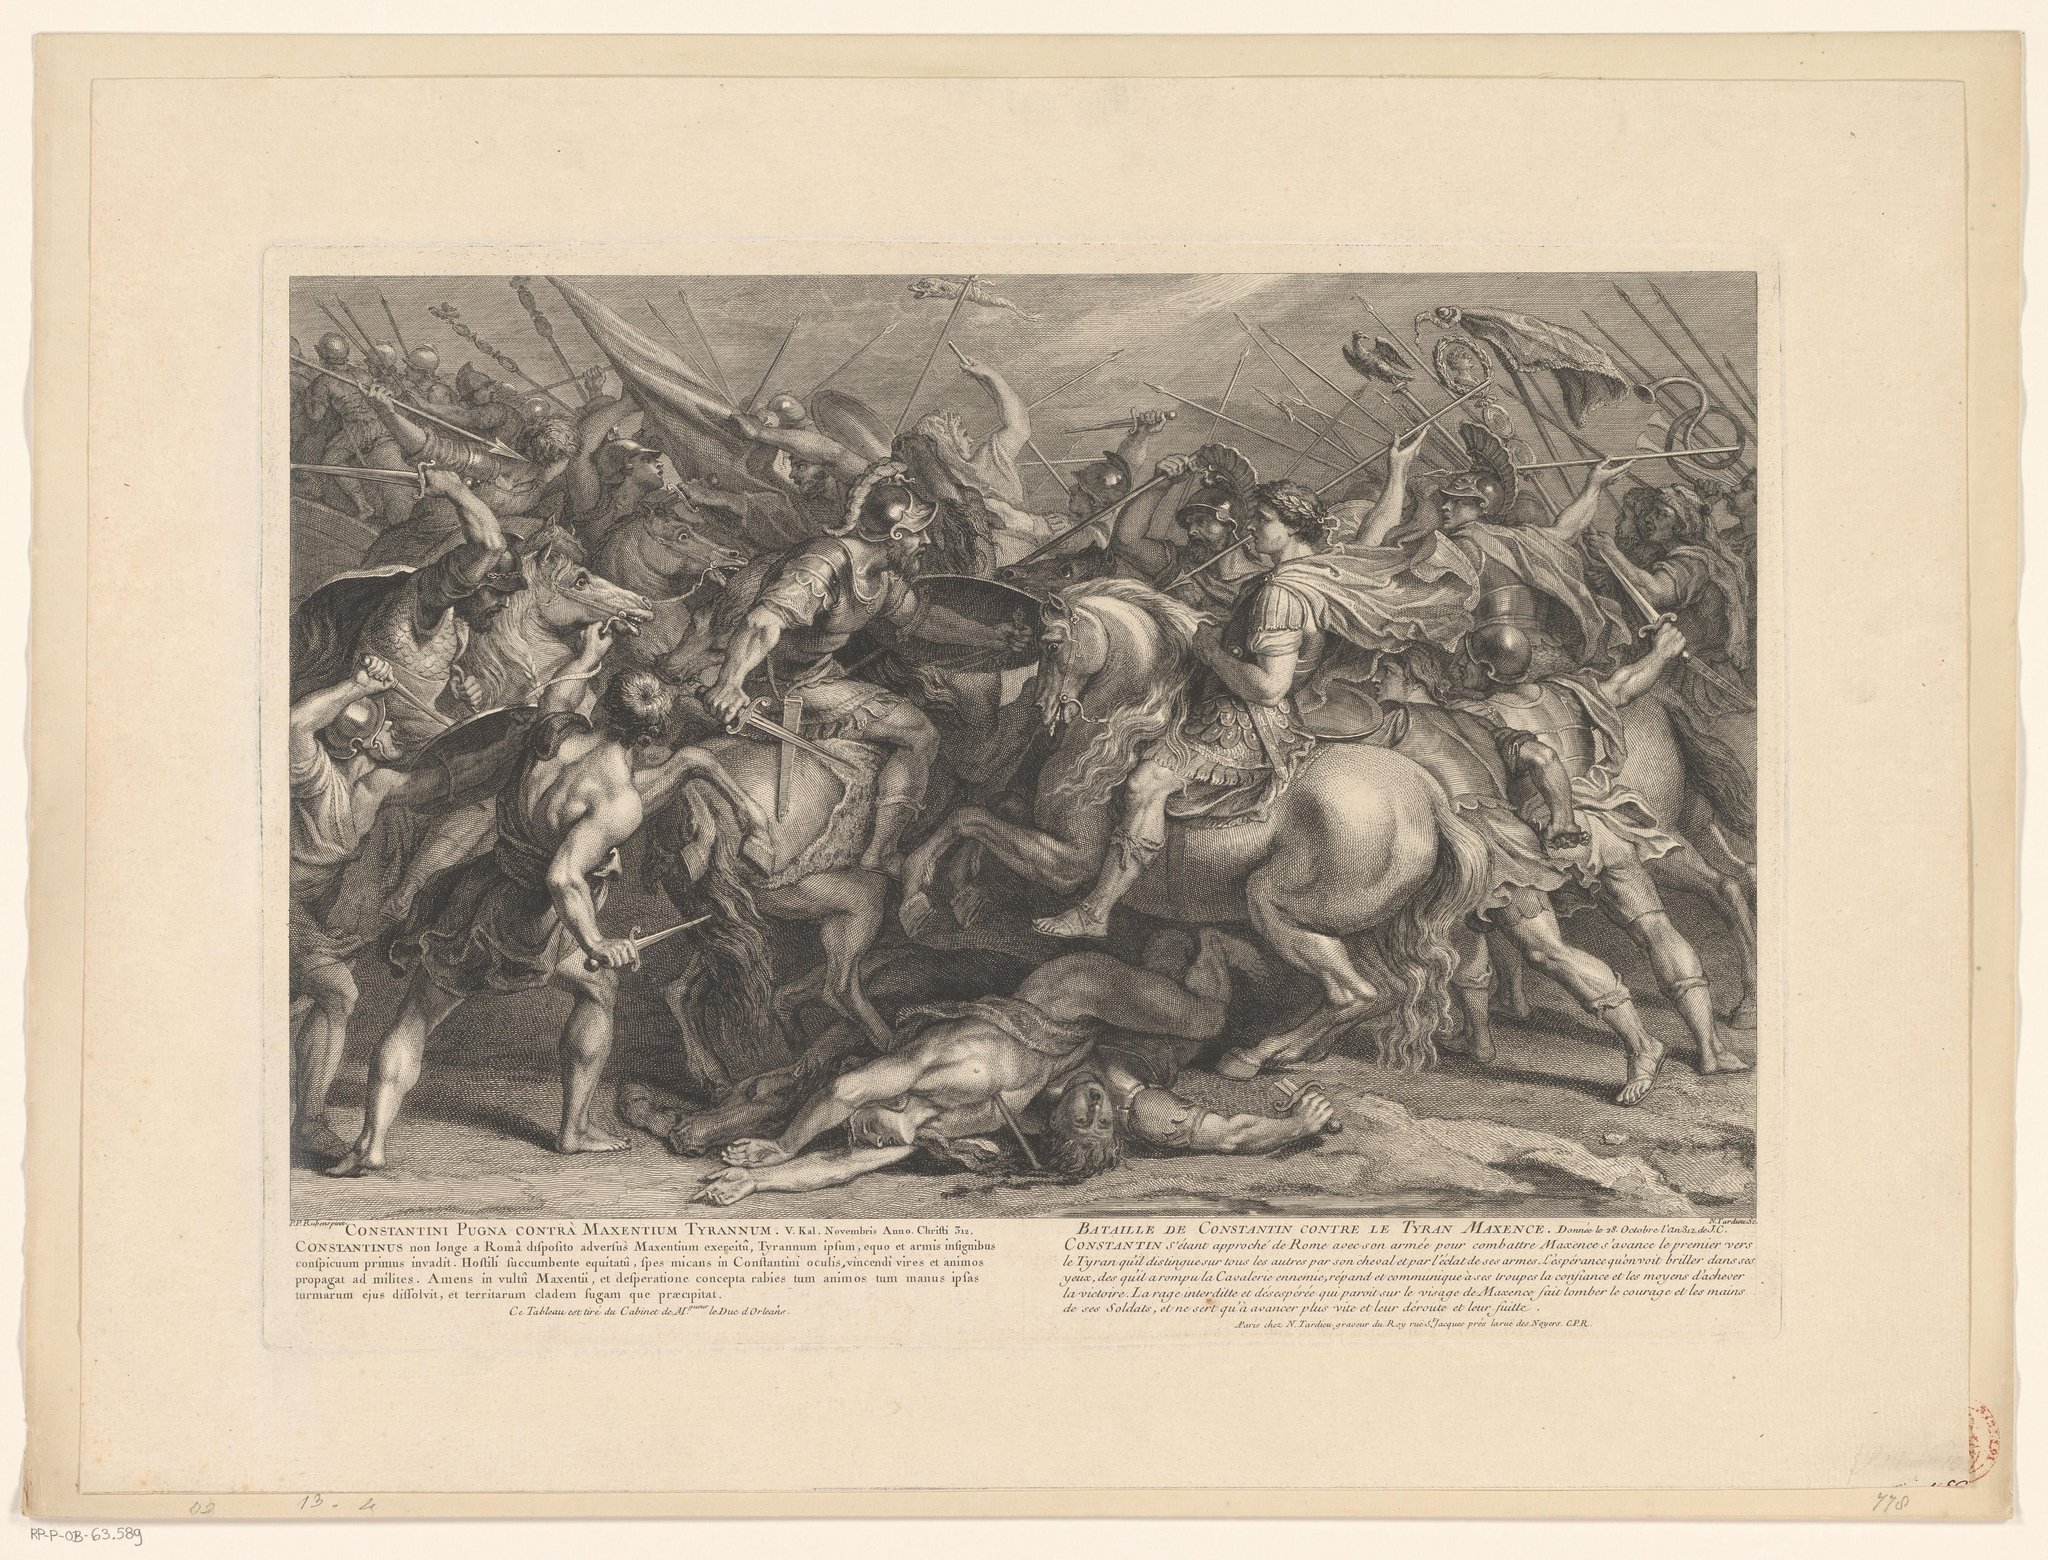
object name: print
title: Slag bij de Milvische brug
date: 1684-1749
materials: paper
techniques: engraving, etching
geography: france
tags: the battle of the milvian bridge (saxa rubra): st. constantine on horseback confronts maxentius; a cross appears in the sky with in fiery letters 'in hoc signo vinces' (the raised standards of the roman soldiers carry a cross or the chi-rho monogram)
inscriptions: collector's mark: Lugt 240